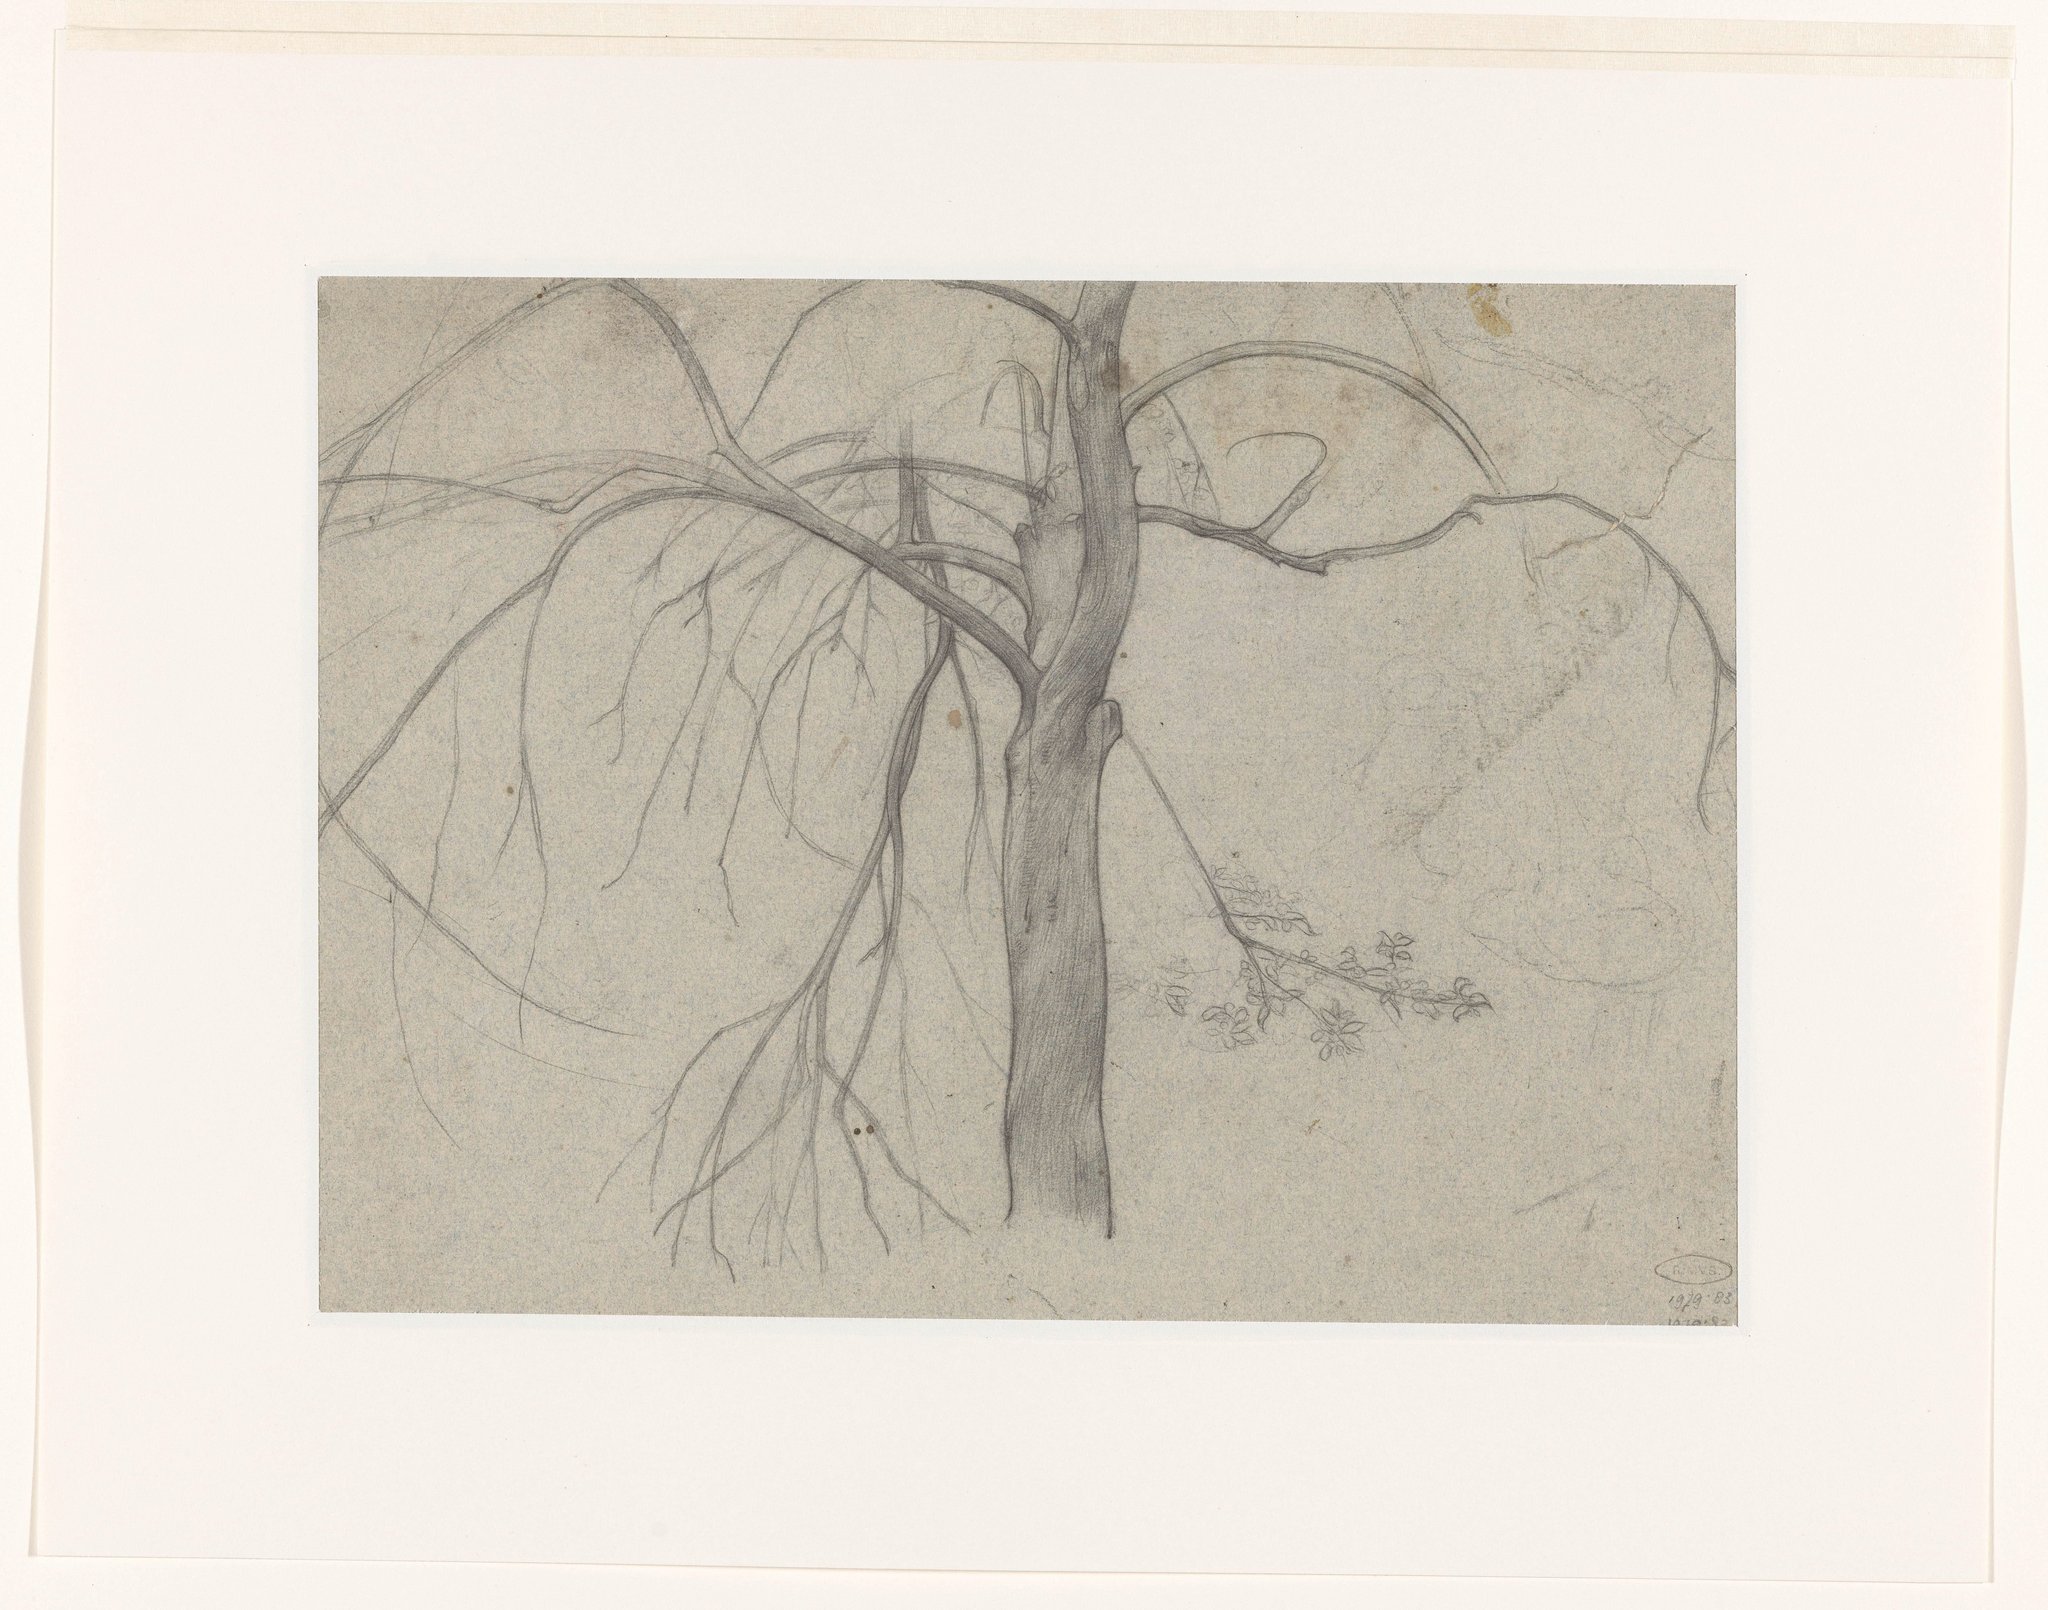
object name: drawing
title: Studie van een boom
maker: richard nicolaüs roland holst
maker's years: 1868-1938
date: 1878-1938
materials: chalk, paper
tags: trees